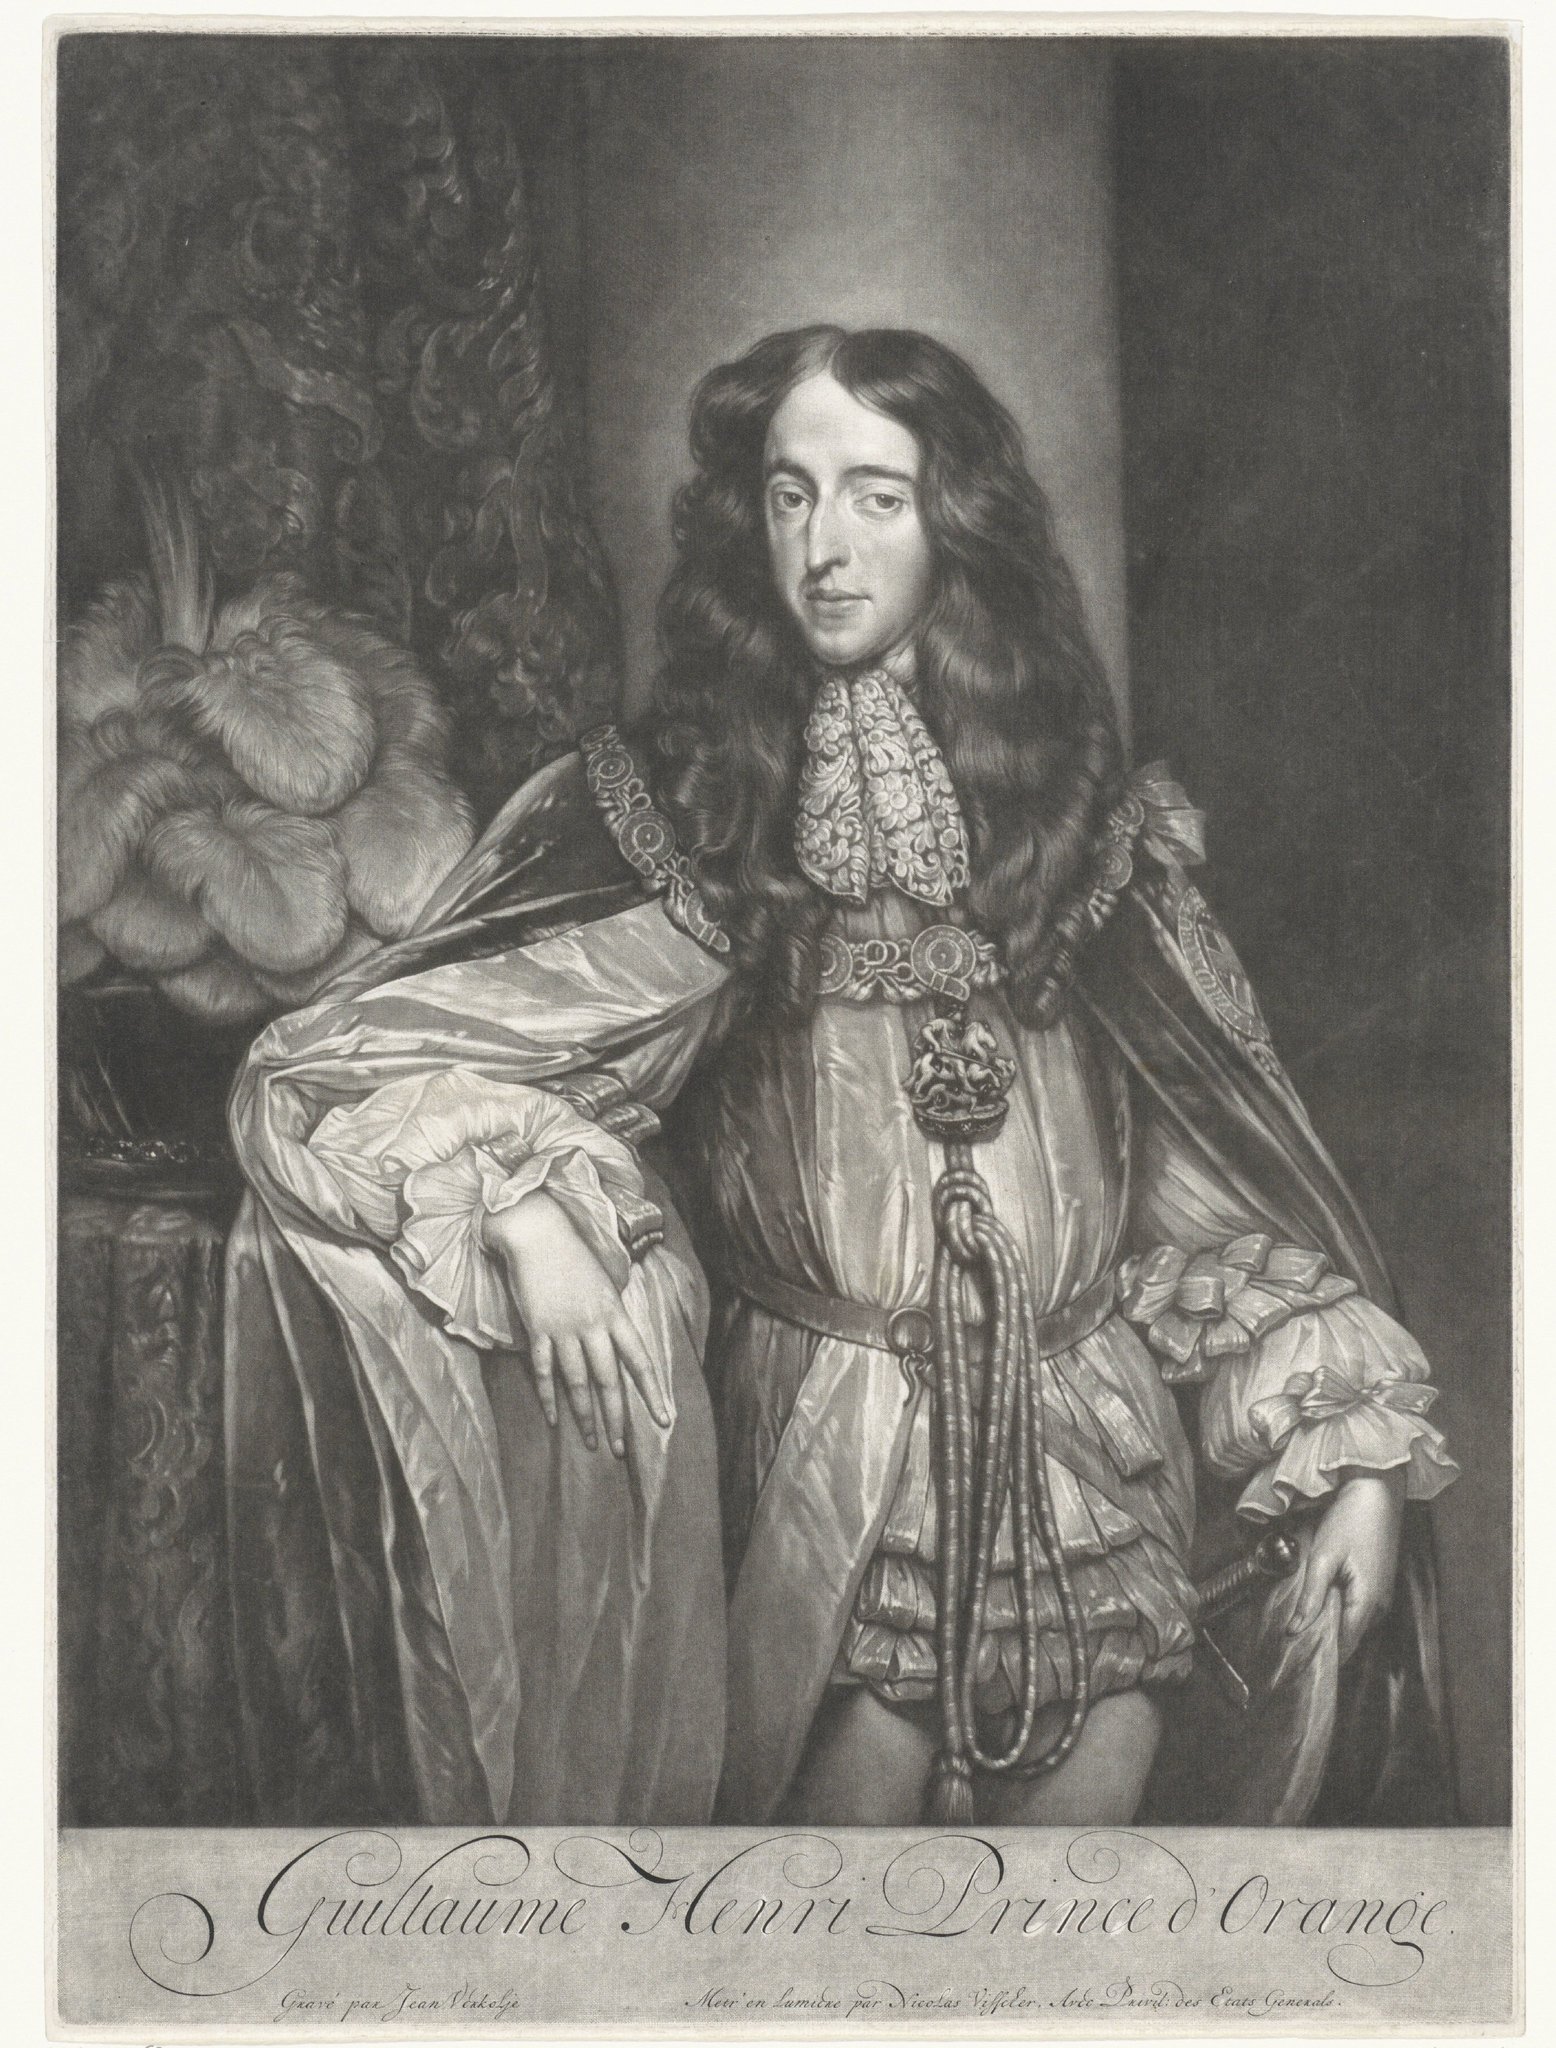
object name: print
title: Portret van Willem III, prins van Oranje-Nassau, koning van Engeland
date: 1660-1693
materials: paper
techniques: mezzotint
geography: amsterdam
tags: the hague, william iii (prince of orange and king of england, scotland, and ireland), crown (symbol of sovereignty), knighthood order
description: Willem III, prins van Oranje-Nassau en sinds 1689 koning van Engeland. Om zijn hals een keten met het ordeteken van de Orde van de Kousenband. Naast hem de koningskroon.